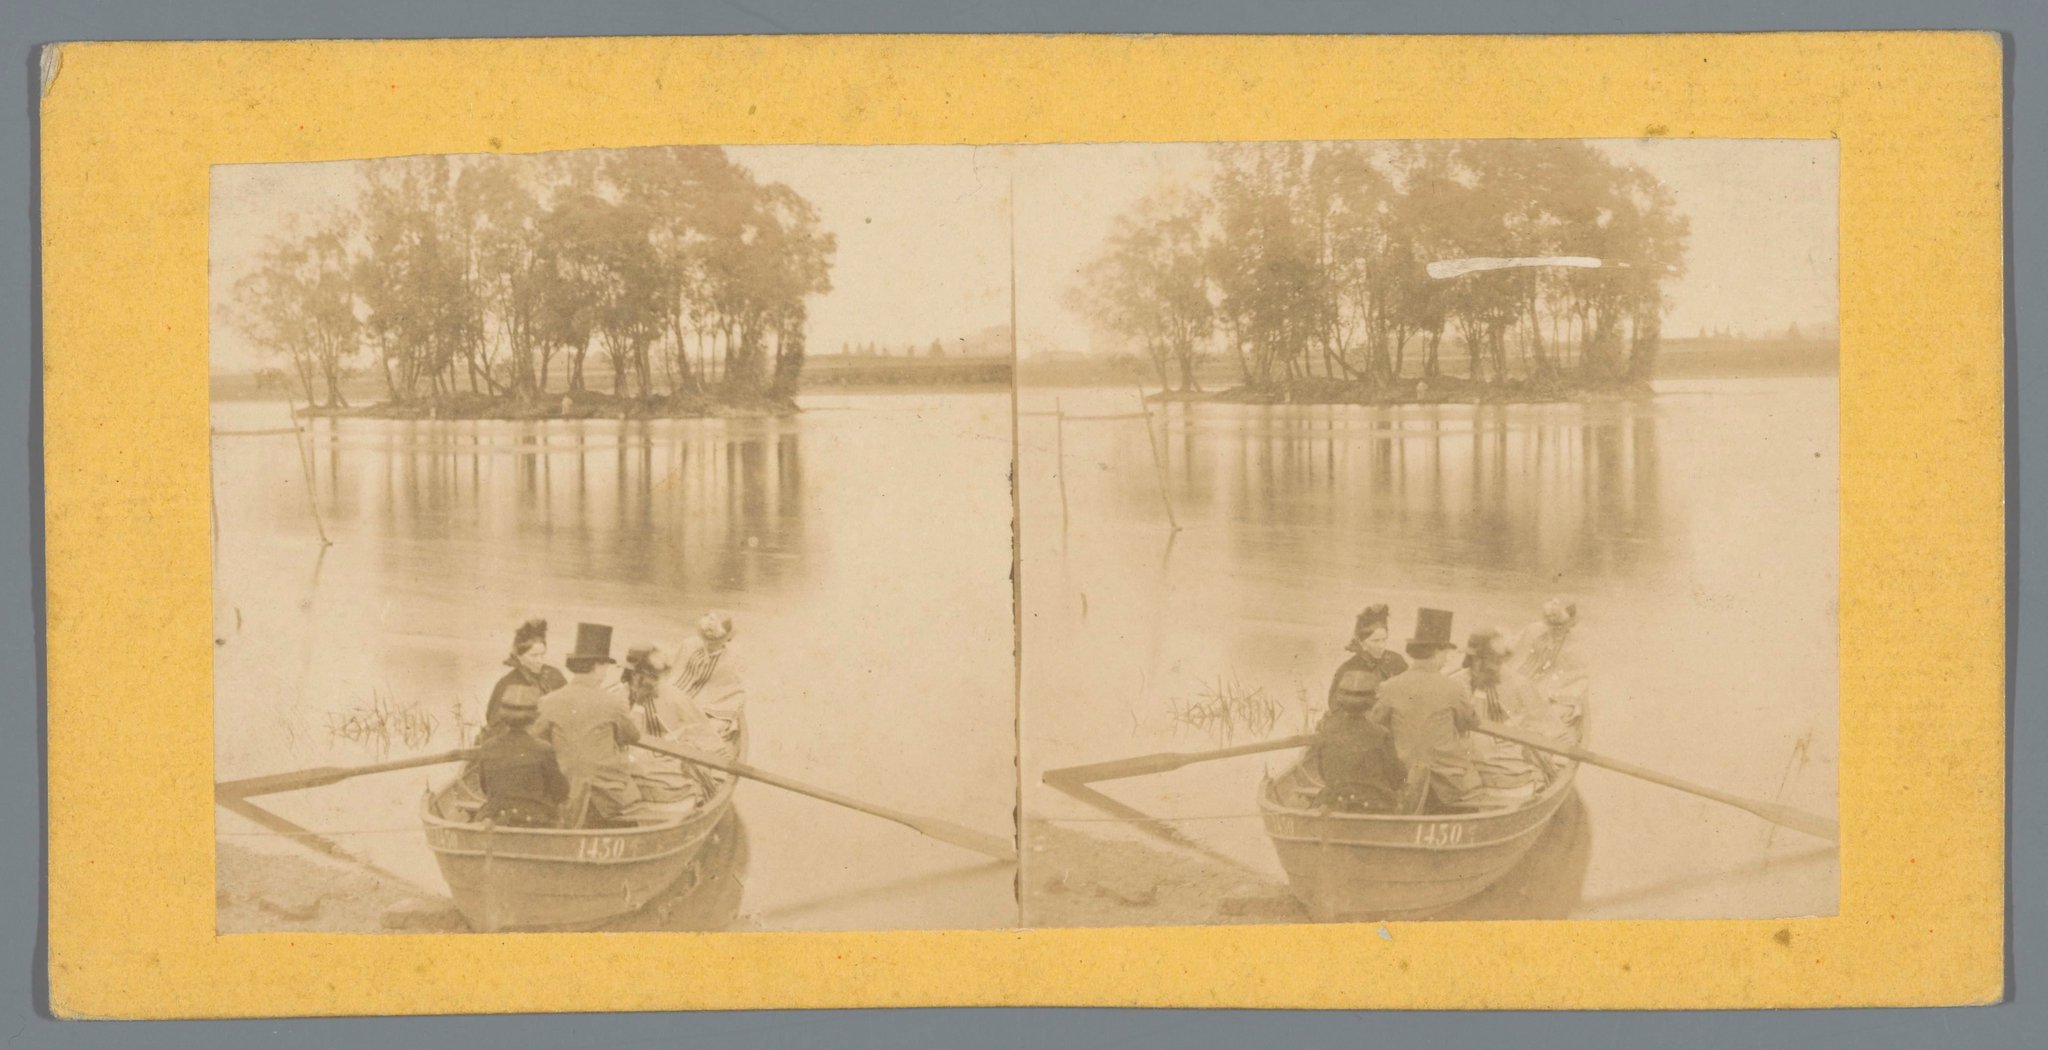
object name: stereograph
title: Gezelschap in een roeiboot op een meer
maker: Anonymous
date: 1850-1880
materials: cardboard, photographic support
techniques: albumen print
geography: europe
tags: rowing-boat, canoe, etc., lake (+ landscape with figures, staffage), europe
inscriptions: inscription: ‘J. 4 210’